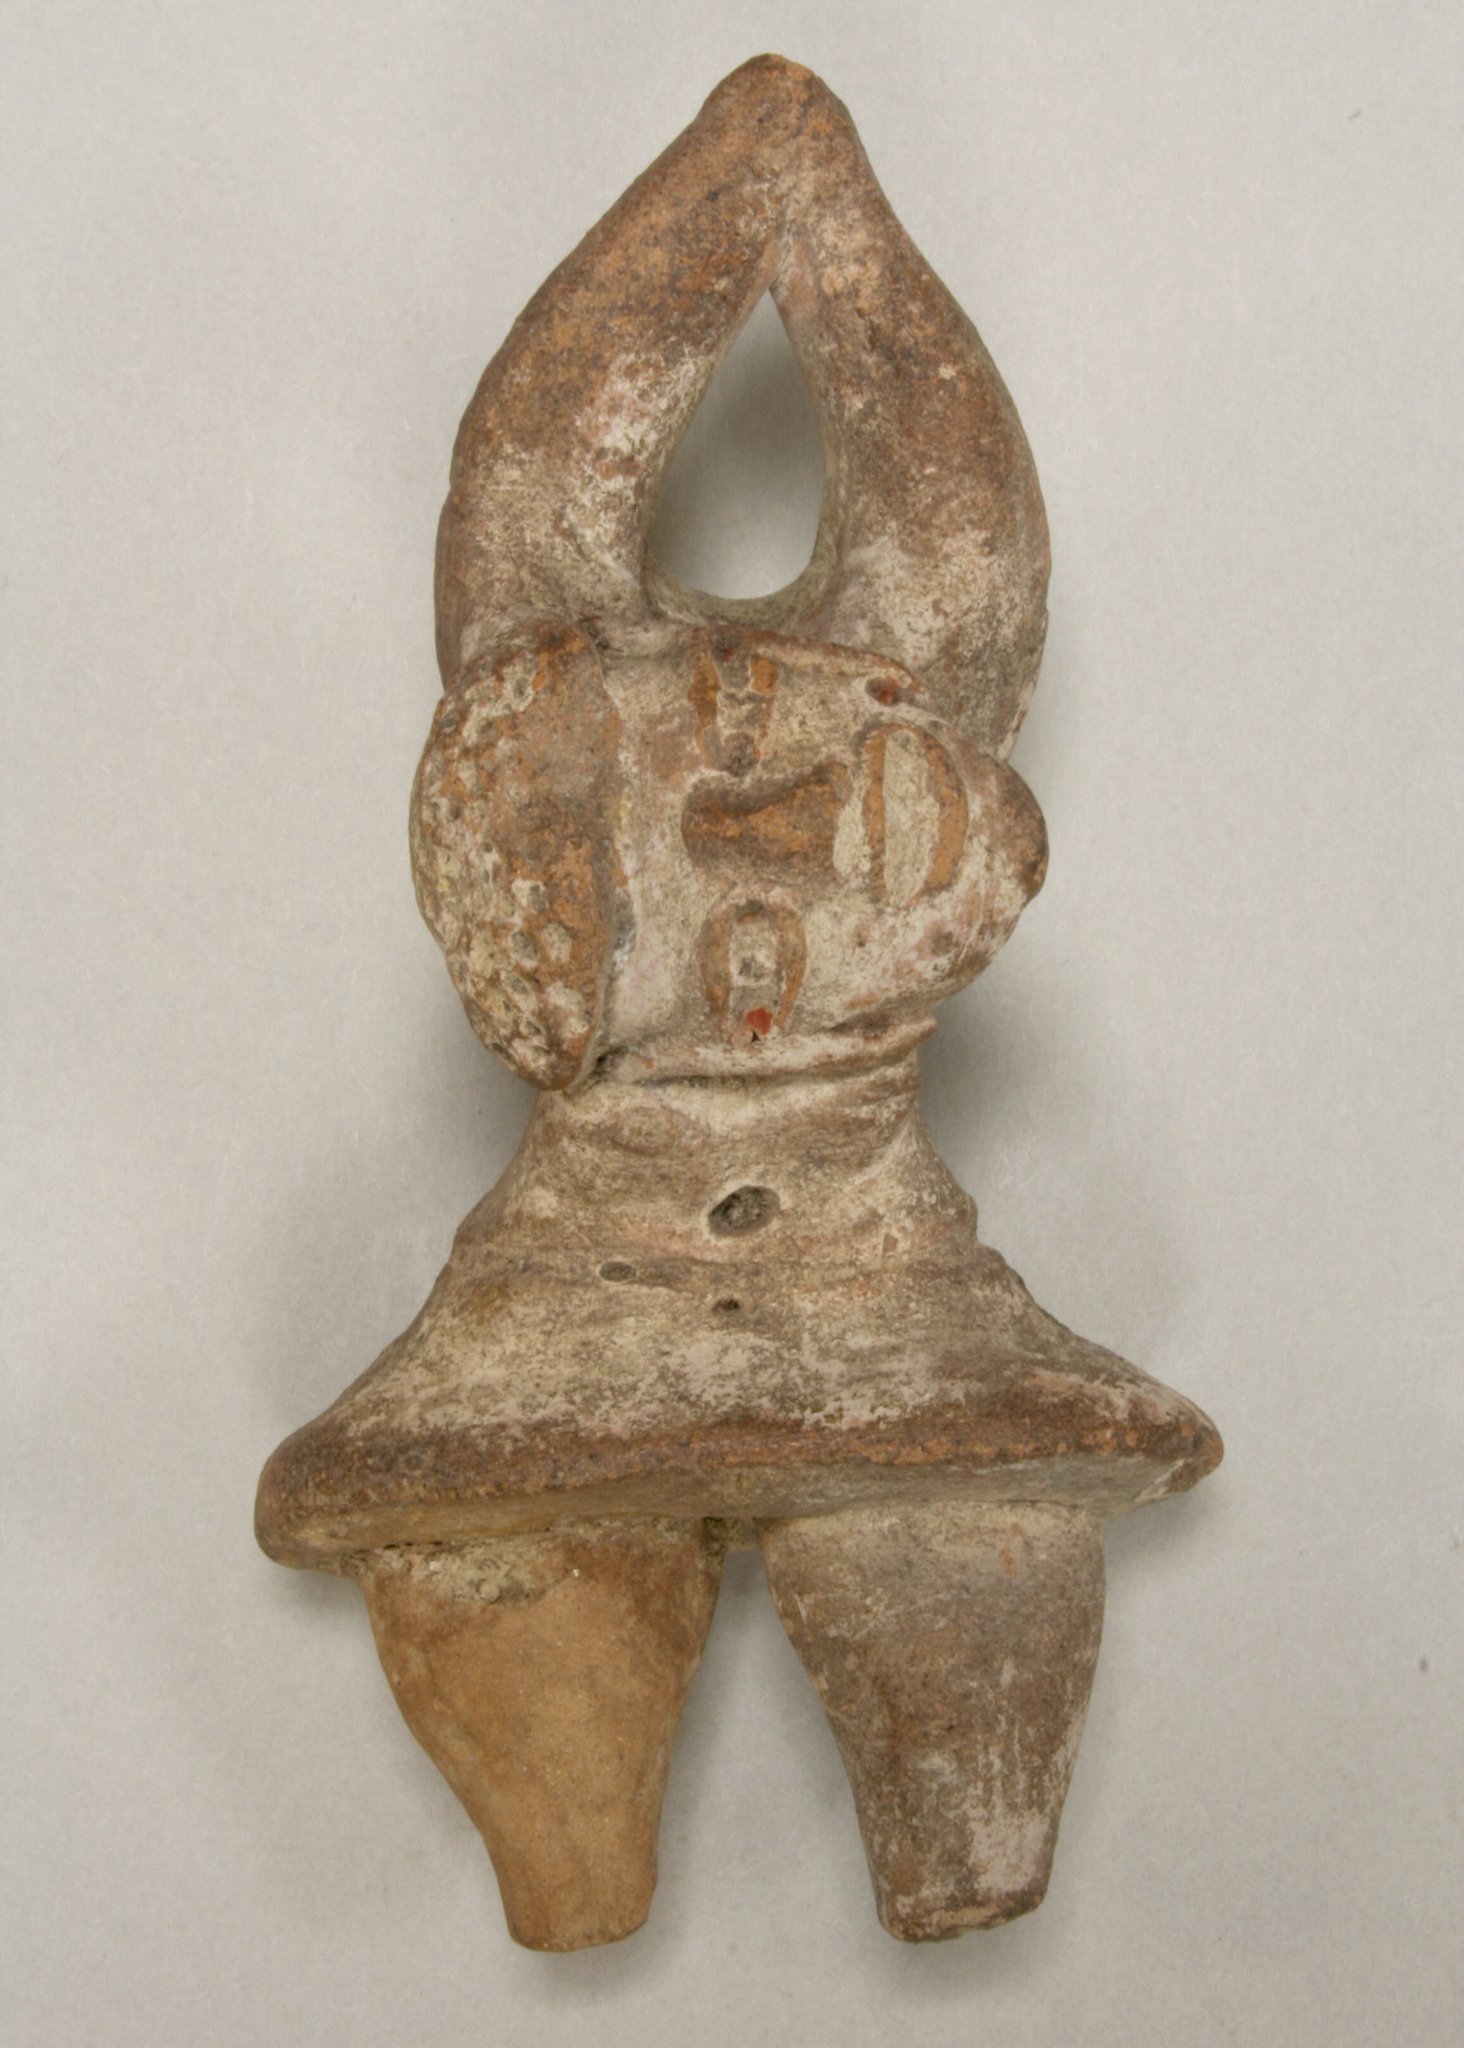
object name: female figure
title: Standing Ceramic Female Figure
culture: tlatilco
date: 1200-801 BCE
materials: ceramic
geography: mexico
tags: women